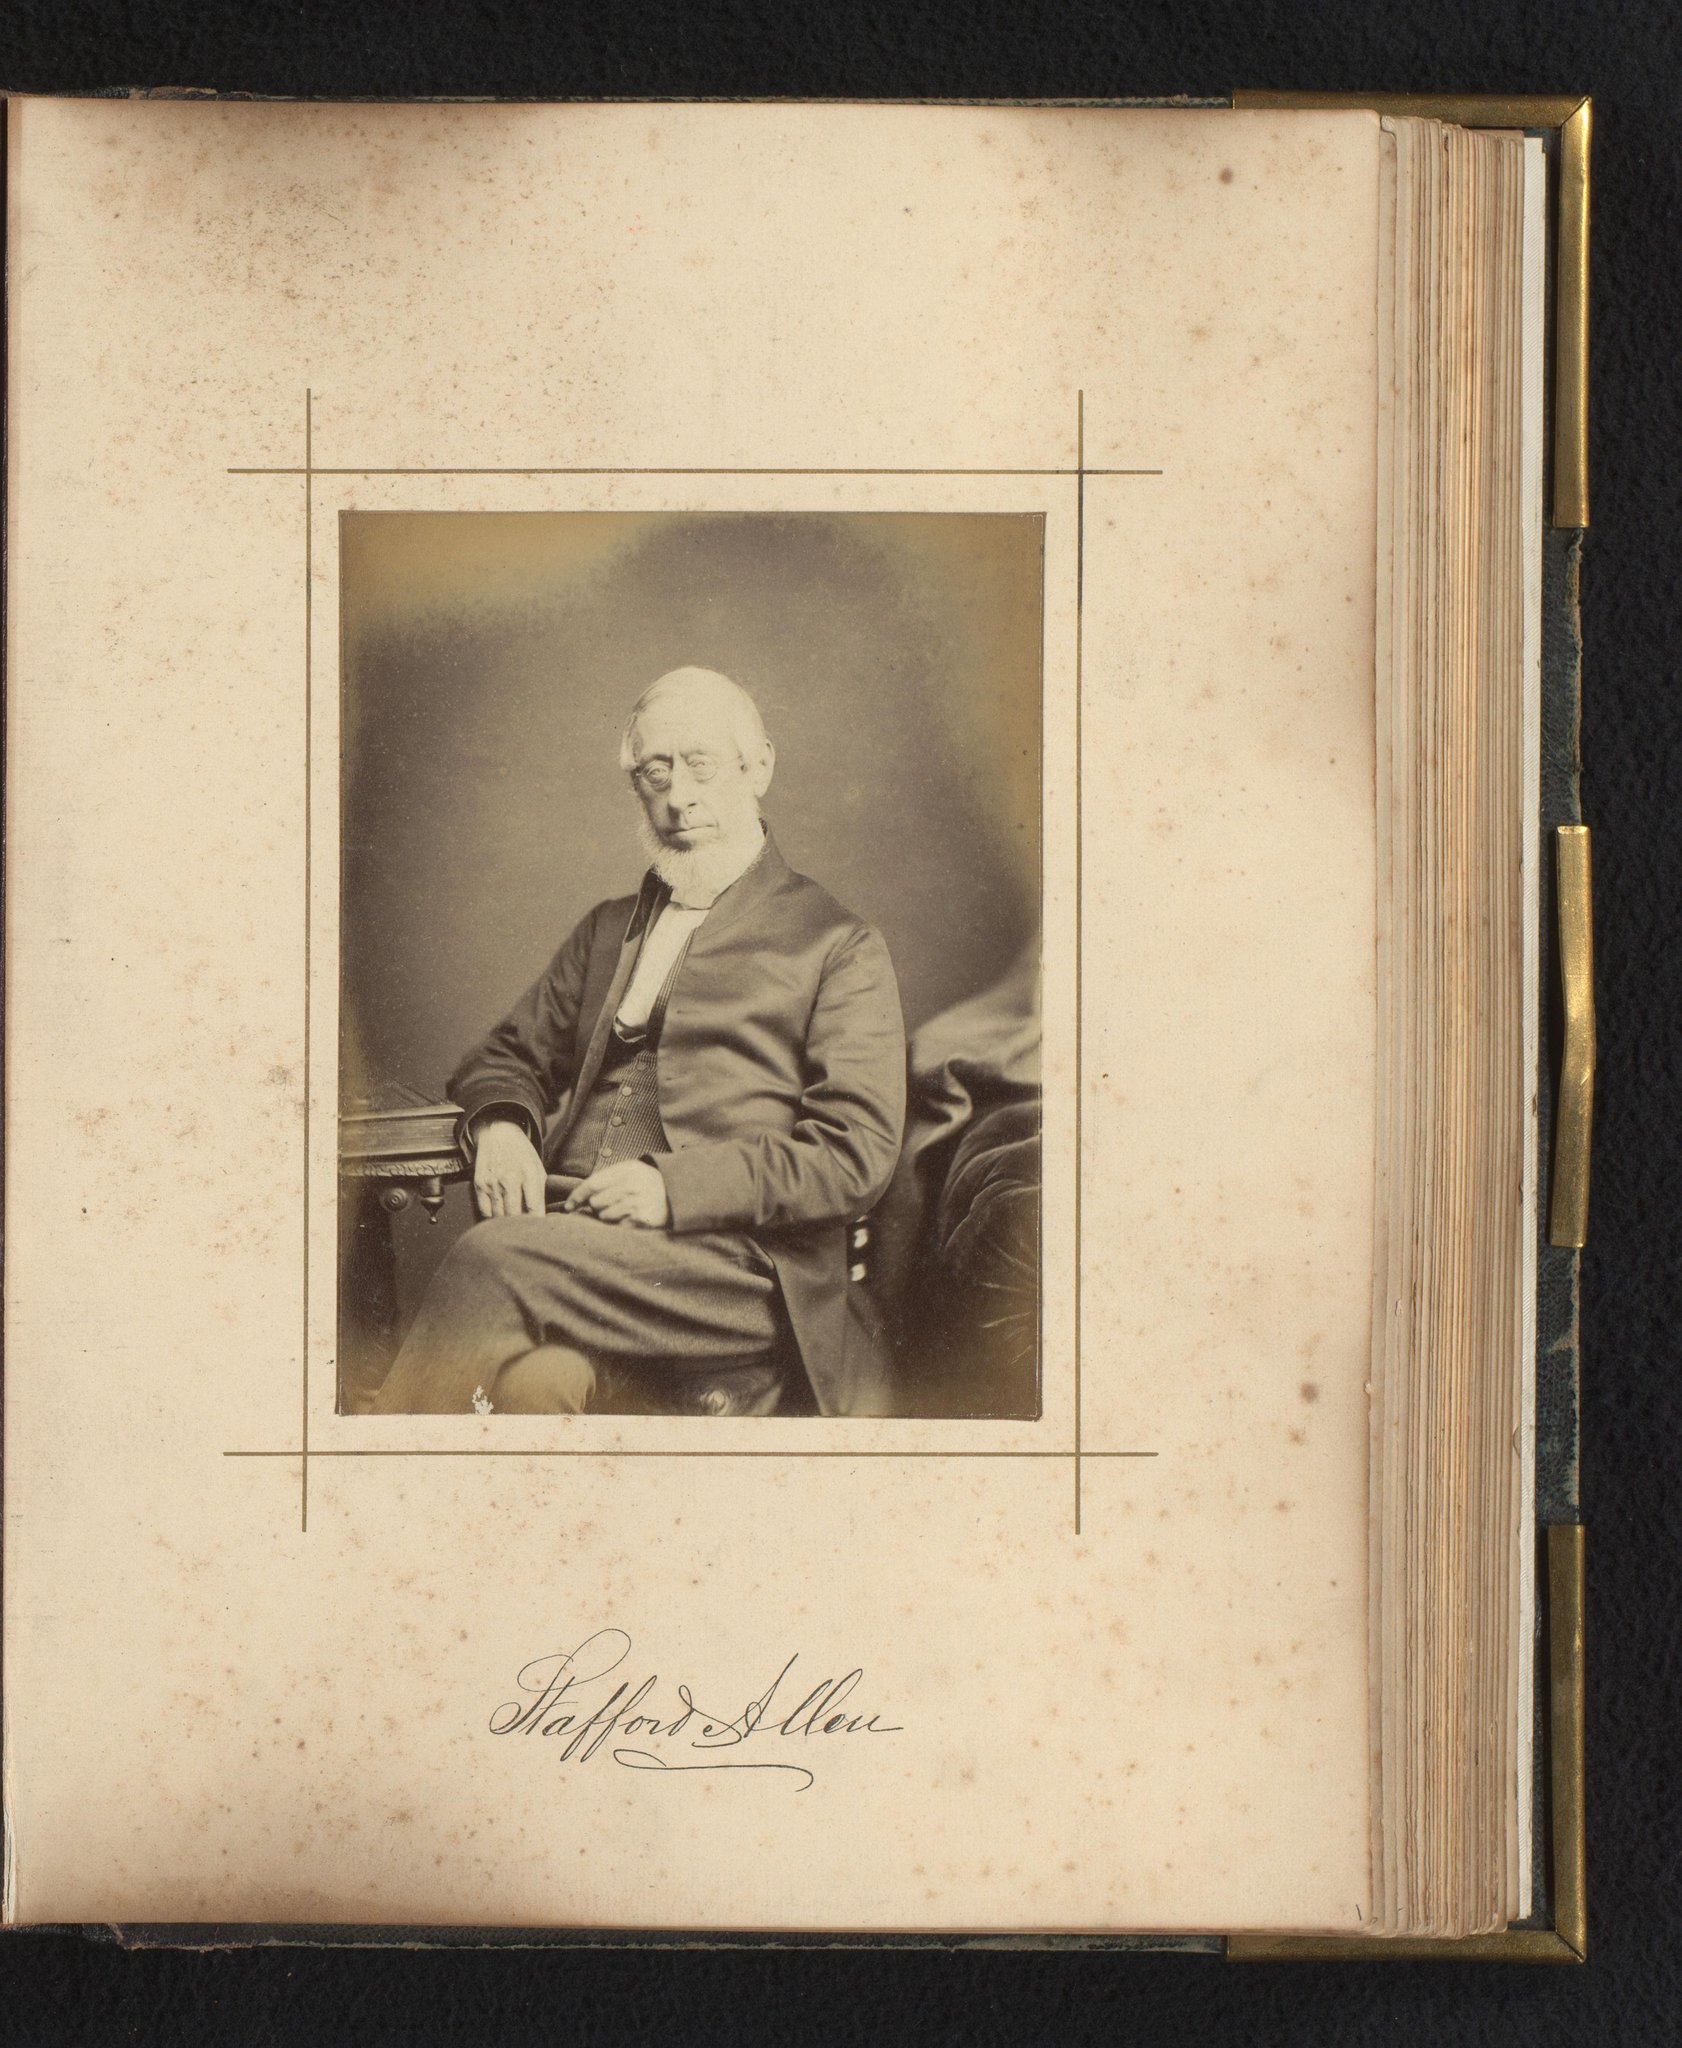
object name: photograph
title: Portret van Stafford Allen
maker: Anonymous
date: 1866-1871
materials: photographic support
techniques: albumen print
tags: historical persons